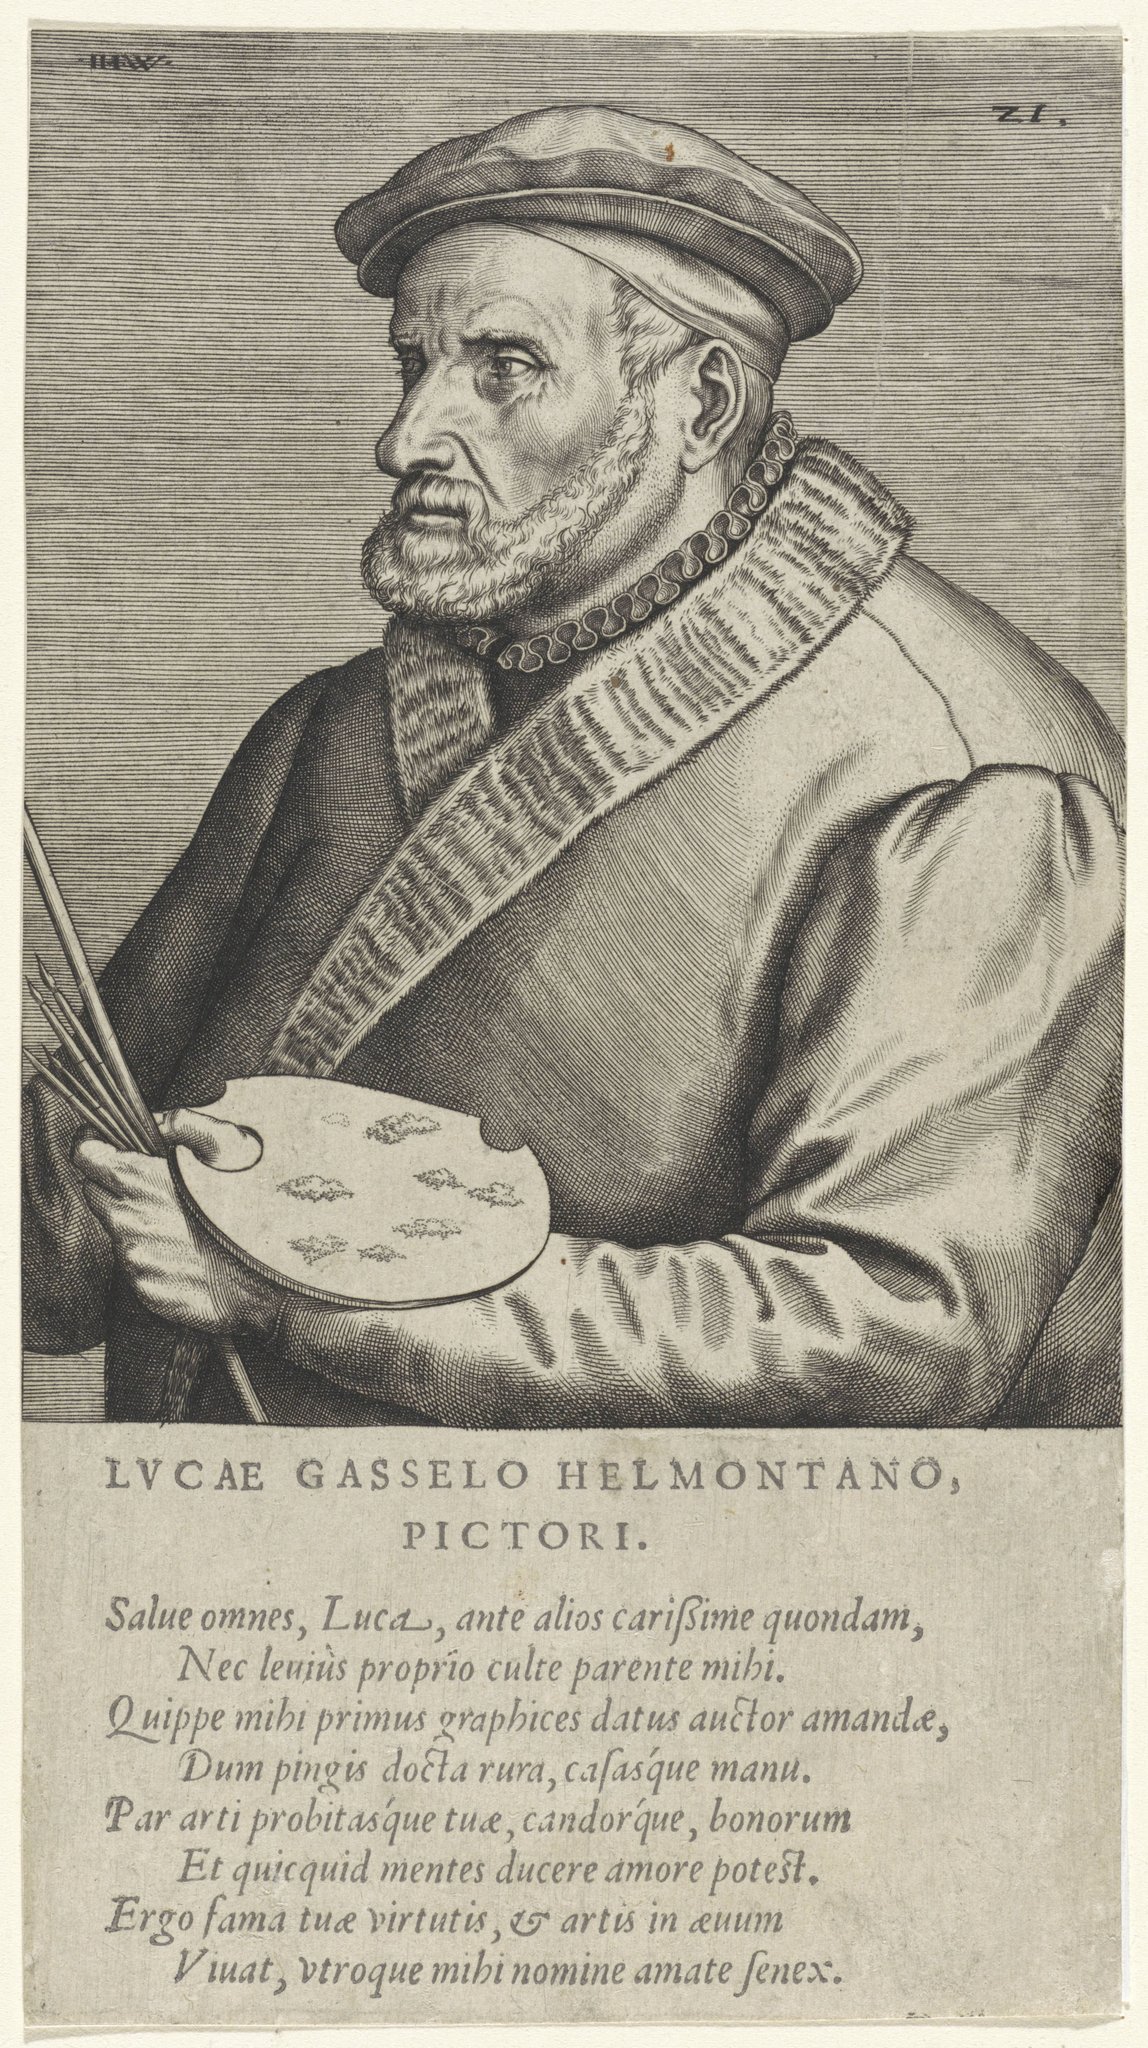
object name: print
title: Portret van de schilder Lucas Gassel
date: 1572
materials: paper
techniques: engraving, letterpress printing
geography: antwerp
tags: print maker, draughtsman, lucas gassel, portrait, self-portrait of painter, palette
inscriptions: collector's mark: Lugt 2165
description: In zijn hand houdt hij een schilderspalet. In de marge een achtregelig onderschrift in het Latijn.